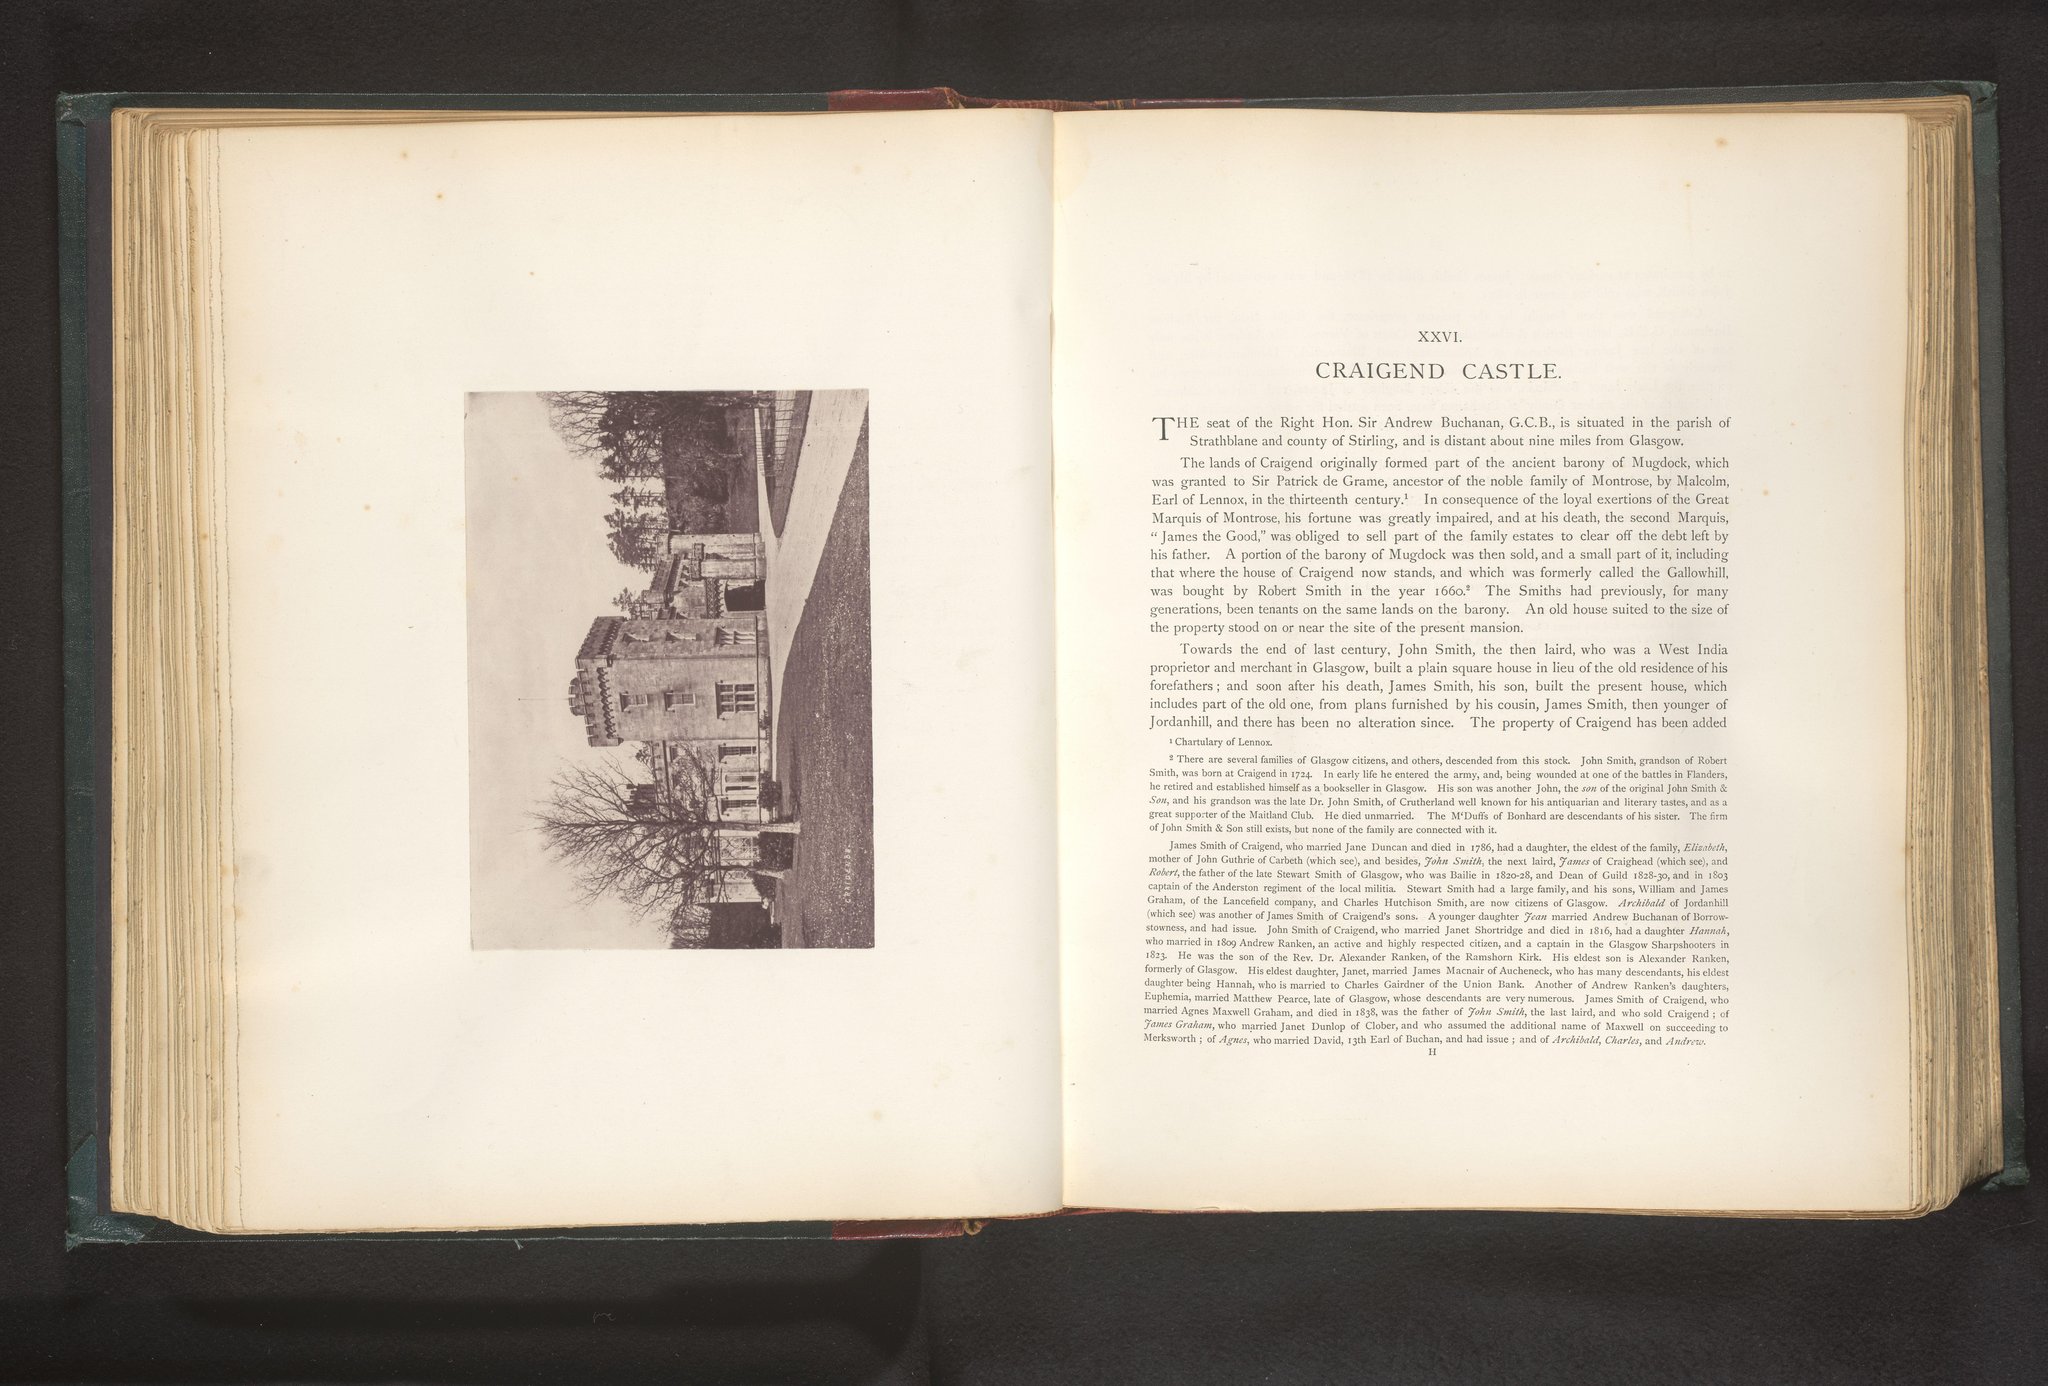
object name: page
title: Craigend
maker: thomas annan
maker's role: fotograaf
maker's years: 1829-1887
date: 1868-1878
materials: paper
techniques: carbon print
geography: east dunbartonshire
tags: castle, façade (of house or building)